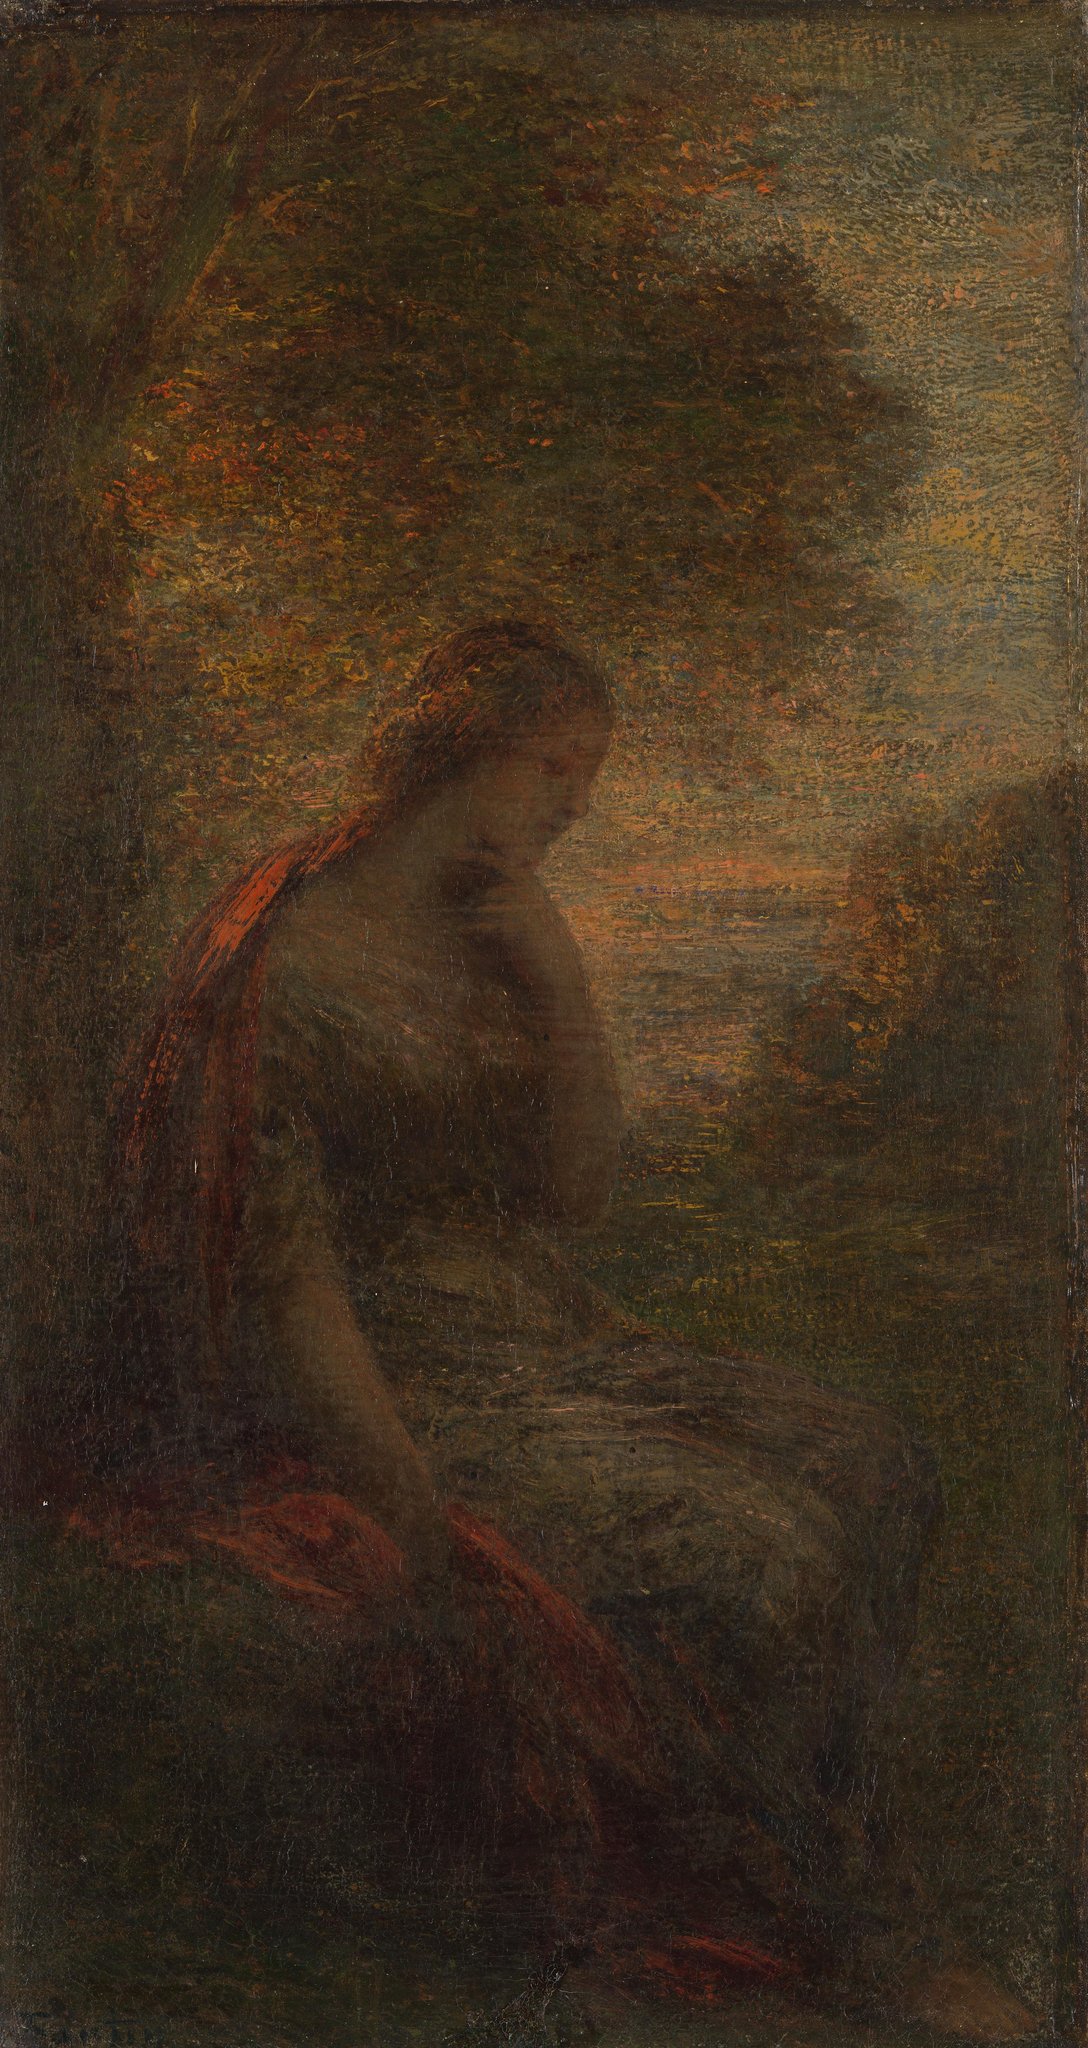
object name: painting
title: Young Woman under a Tree at Sunset, called 'Autumn'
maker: henri fantin-latour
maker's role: draughtsman, print maker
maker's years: 1836-1904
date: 1855-1900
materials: canvas, oil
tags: sitting figure - aa - female human figure, autumn ~ other concepts (e.g. biblical scenes) (the four seasons of the year)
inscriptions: signature: ‘Fantin’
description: Een jonge vrouw zittend onder een boom bij zonsondergang, genaamd 'Herfst'.